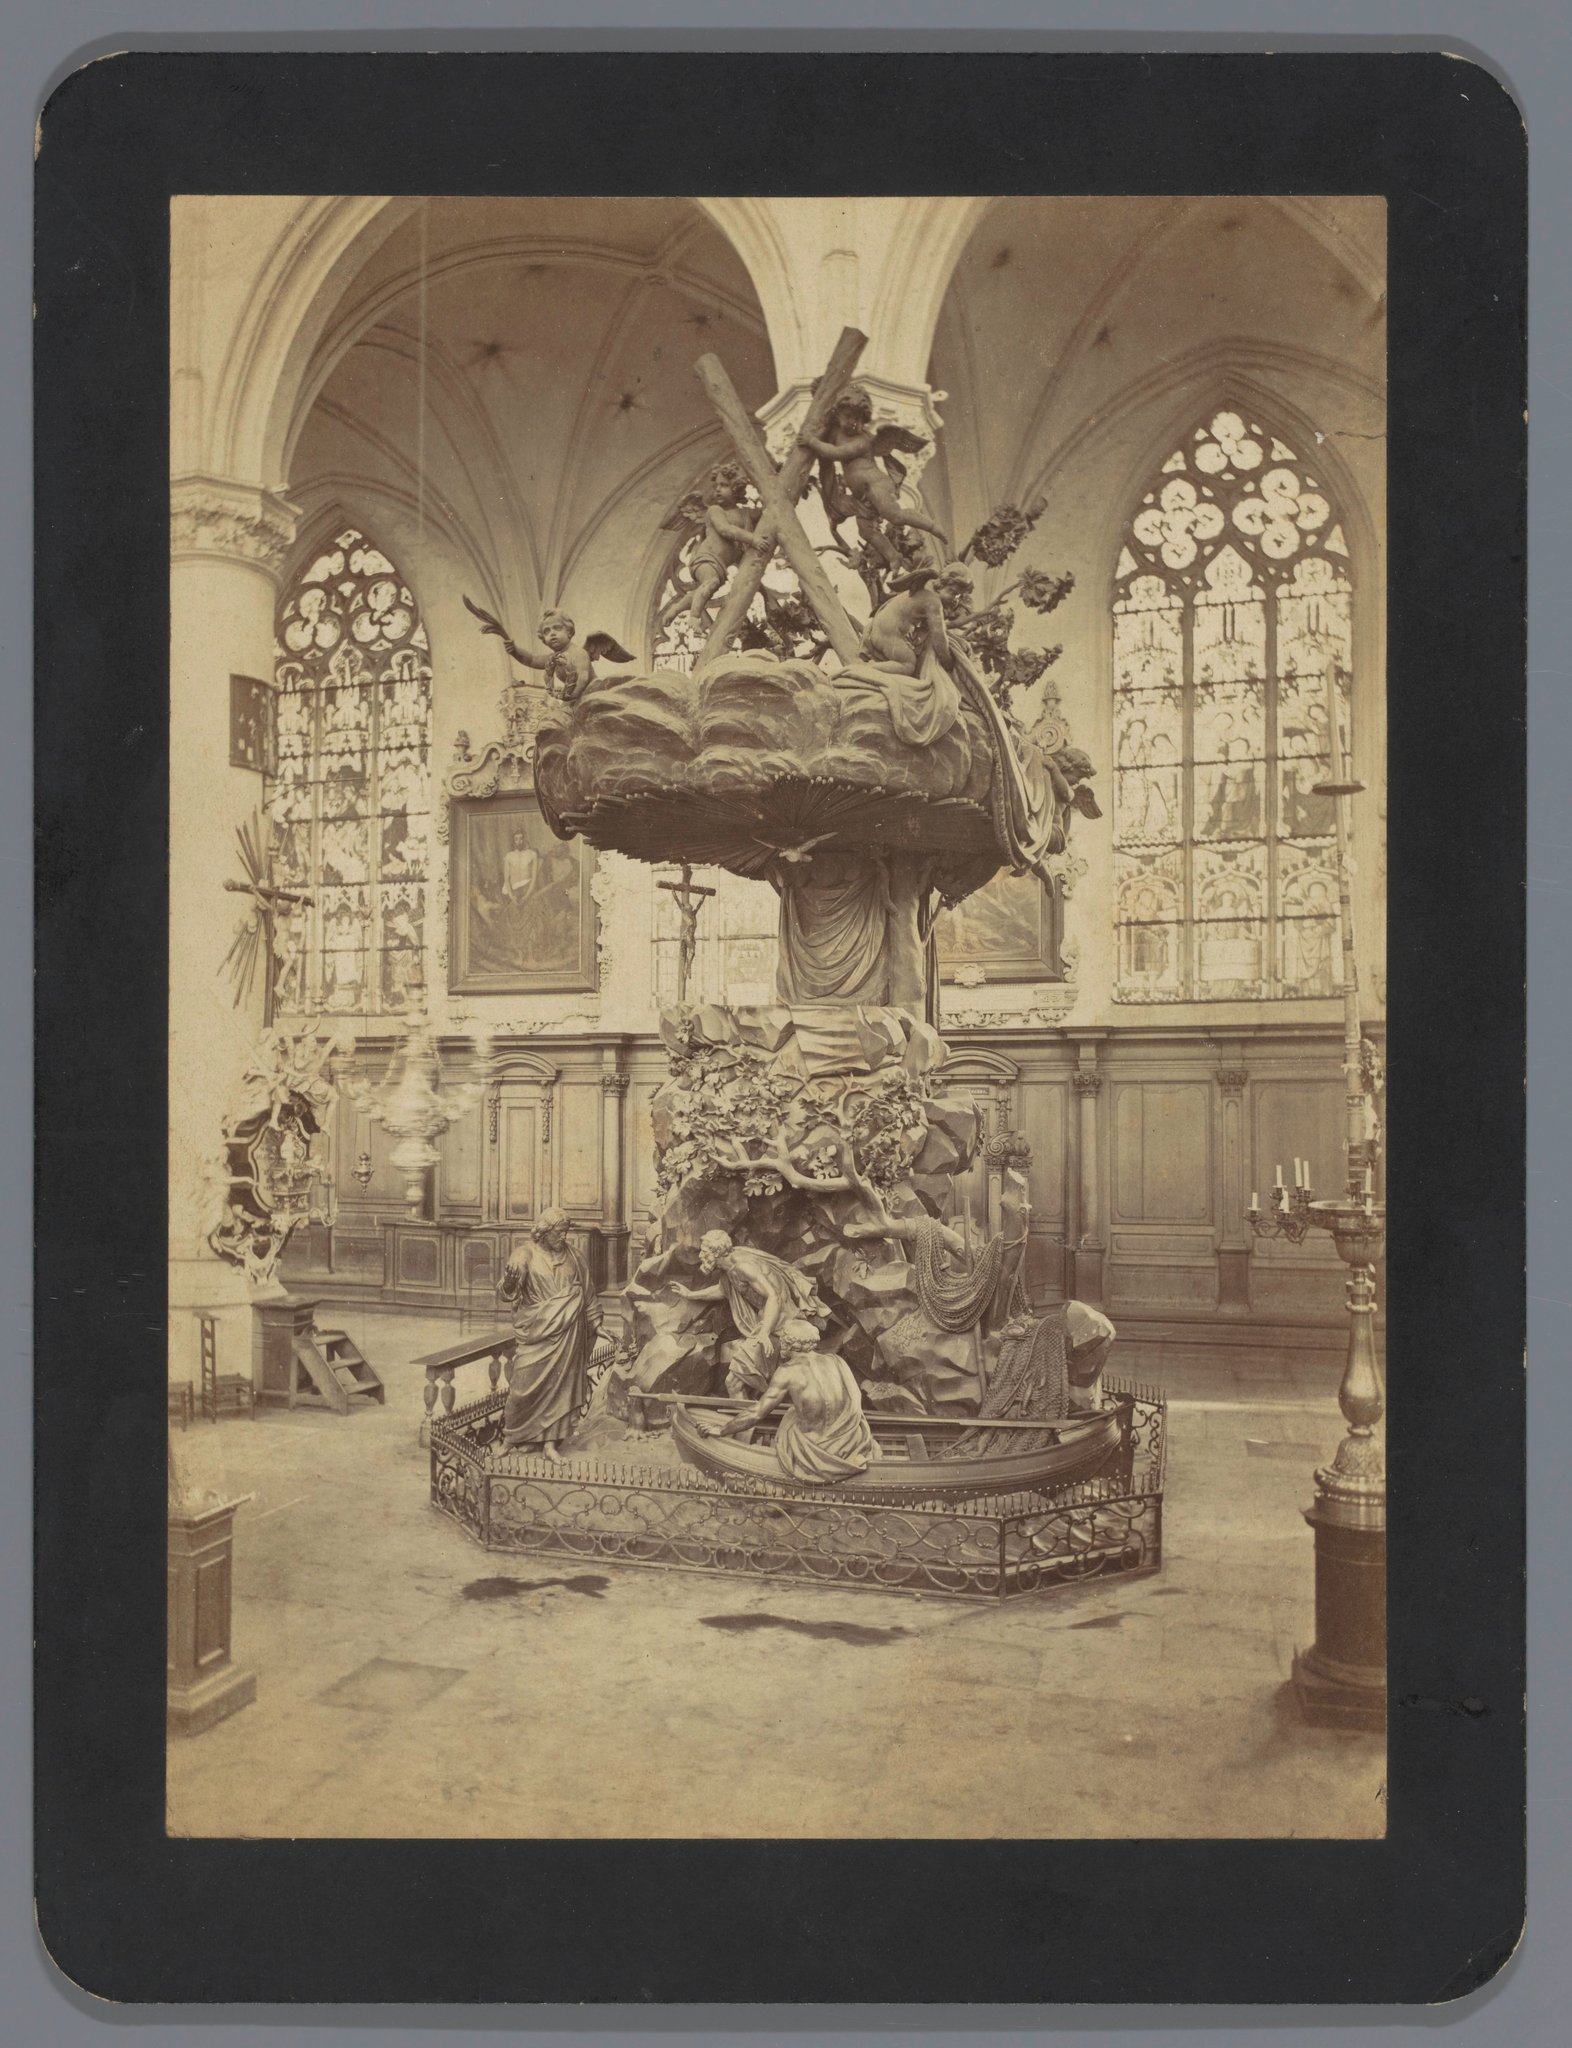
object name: photograph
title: Preekstoel in de Sint-Andrieskerk te Antwerpen, België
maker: Anonymous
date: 1860-1900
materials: cardboard, paper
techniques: albumen print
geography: antwerp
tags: pulpit, ambo, chancel, antwerp